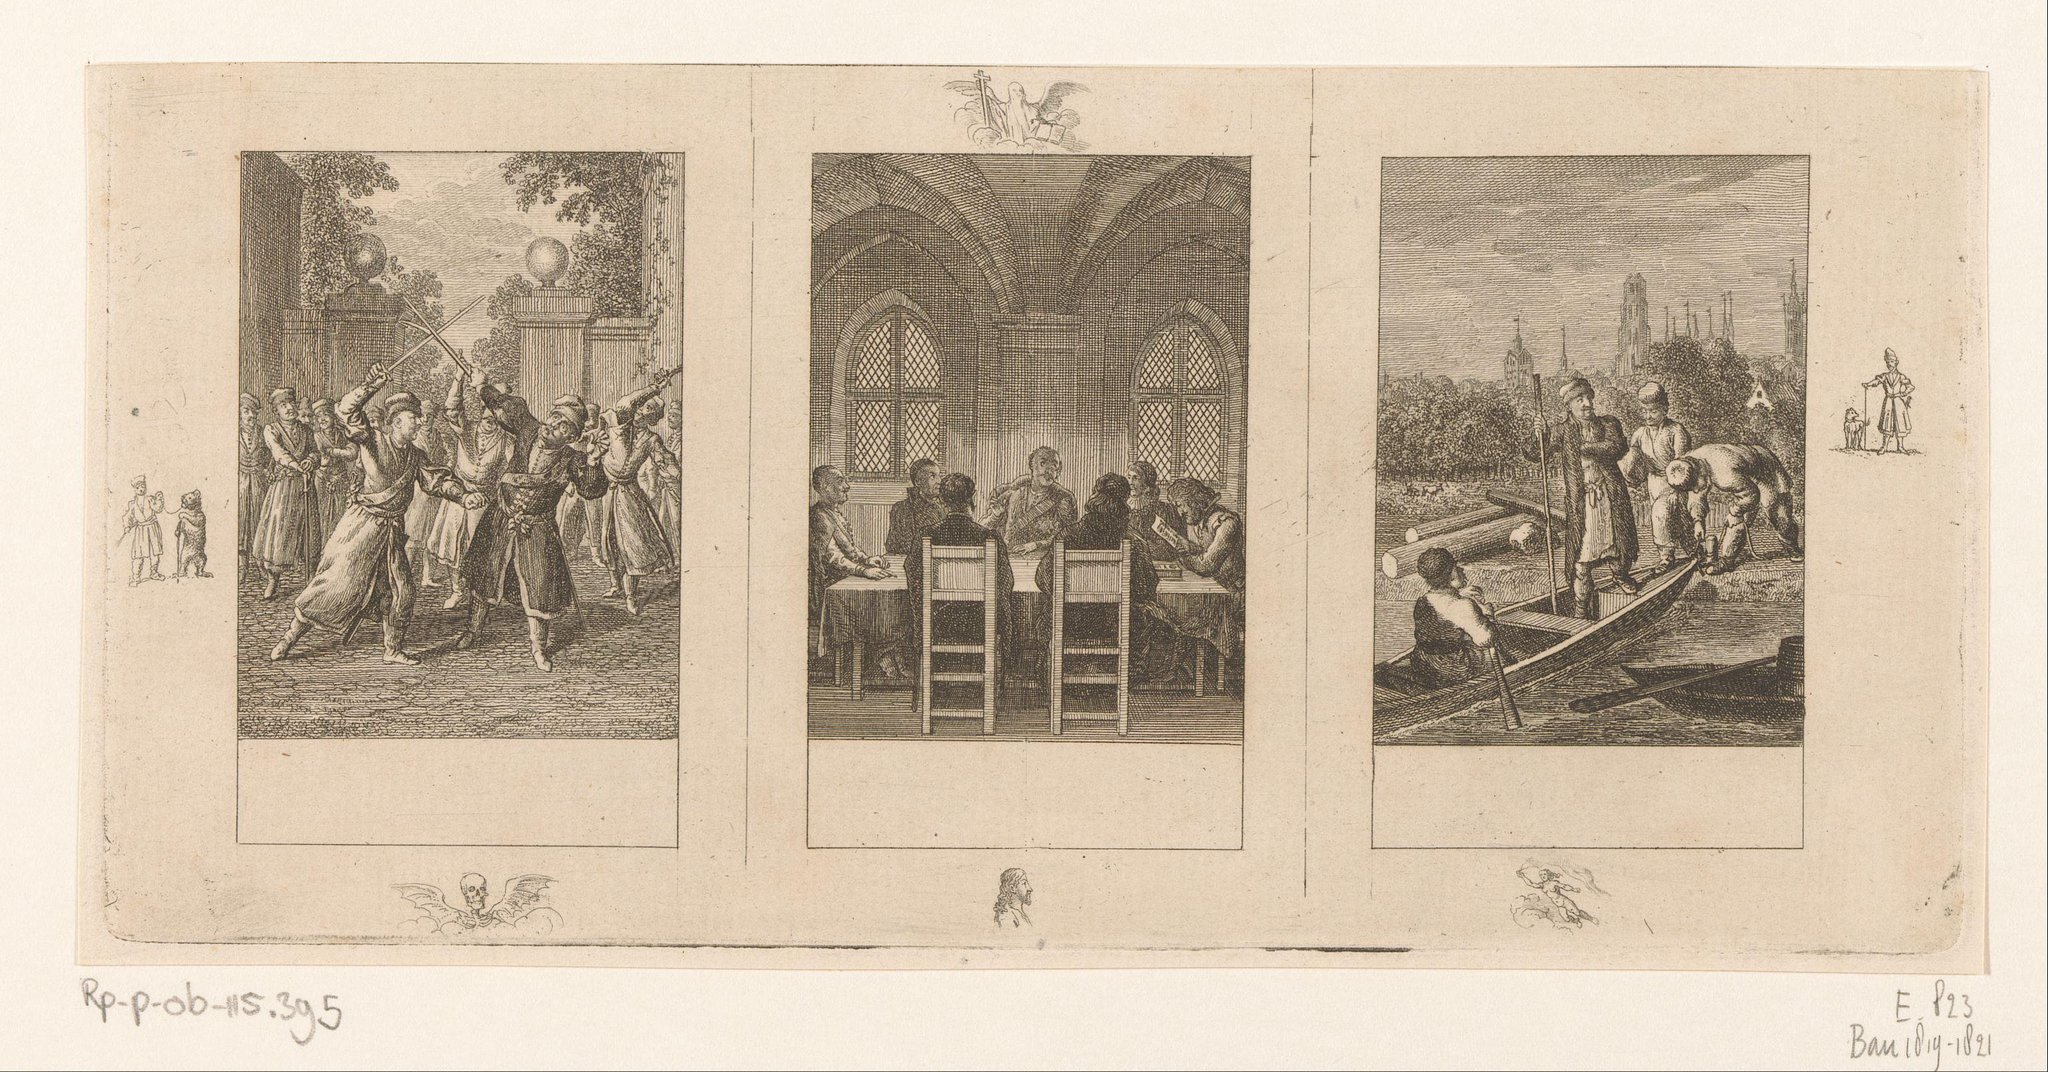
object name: print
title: Drie voorstellingen uit de geschiedenis van Polen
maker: daniel nikolaus chodowiecki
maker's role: draughtsman, print maker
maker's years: 1726-1801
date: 1796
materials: paper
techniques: etching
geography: berlin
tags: history, earning money with bear, death as skeleton, rowing-boat, canoe, etc., flight, running away; pursuing, conversation, dialogue; conversation piece, duelling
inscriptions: collector's mark: Lugt 2228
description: Latere staat gebruikt voor: Historisch-genealogischen Kalender auf das Gemeinjahr 1797. Enthält die Geschichte von Polen (...). Berlijn: Johann Friedrich Unger, [1796].